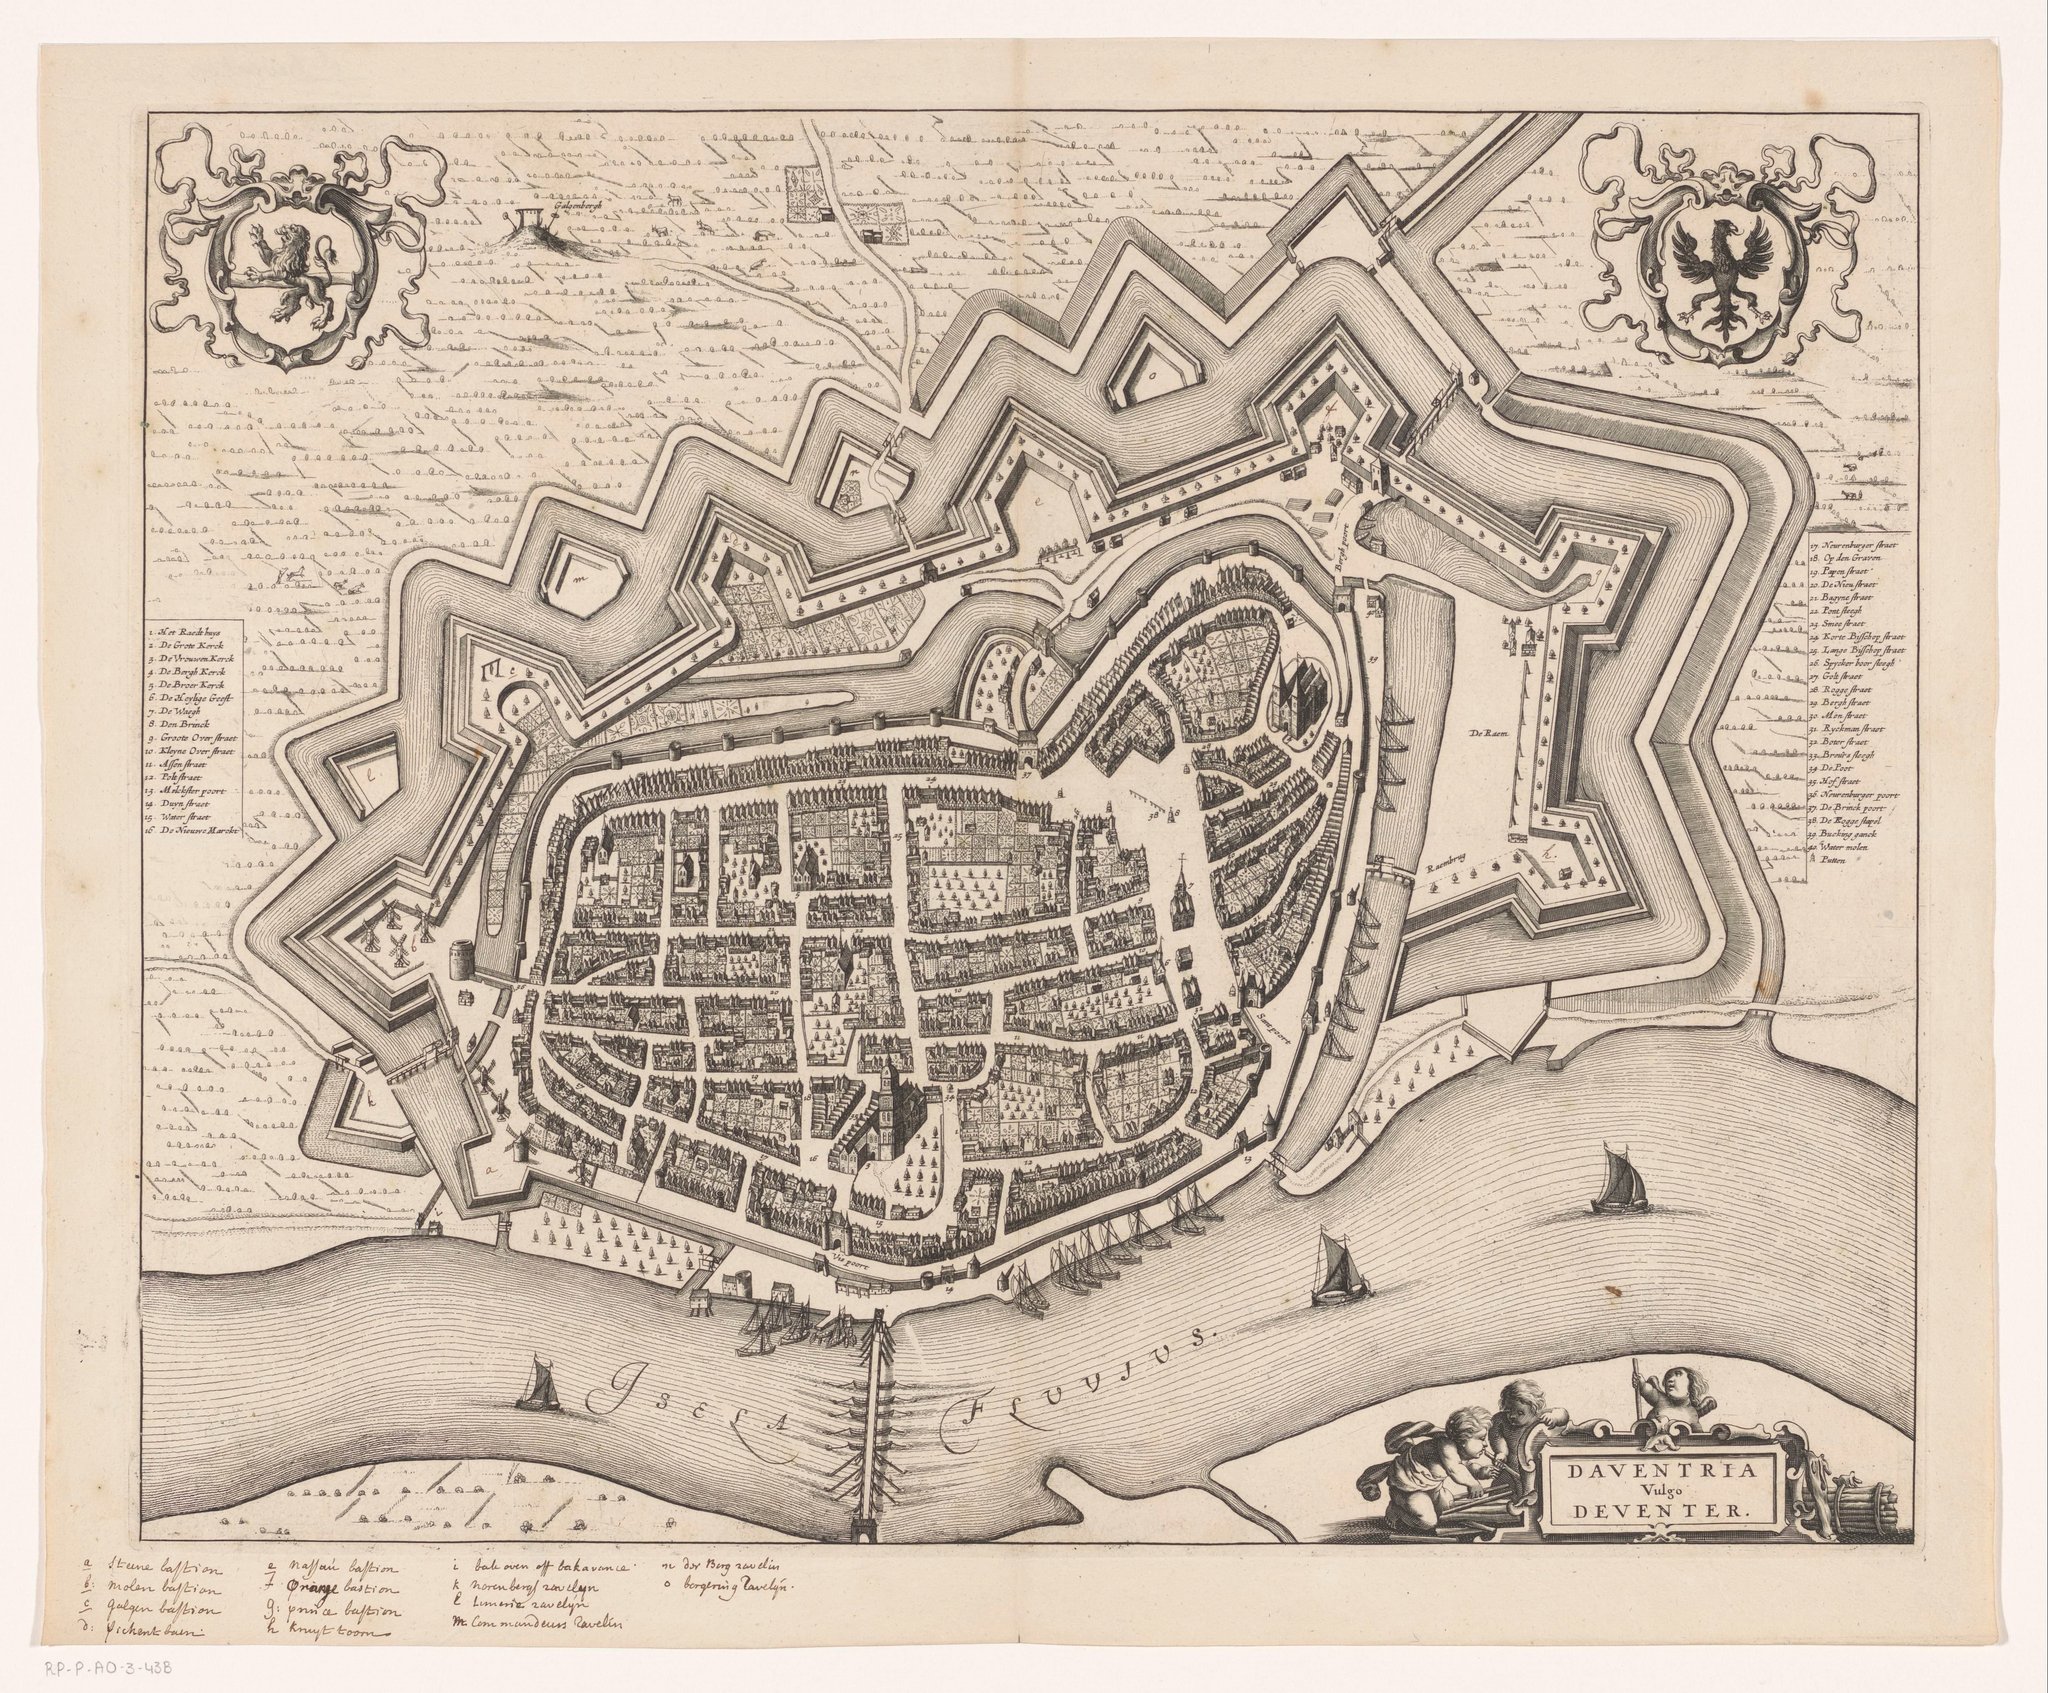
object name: area plan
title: Plattegrond van Deventer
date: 1657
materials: ink, paper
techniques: engraving, etching, pen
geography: amsterdam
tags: coat of arms (as symbol of the state, etc.), maps of cities, deventer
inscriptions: inscription: ‘a. steene bastion, b. molen bastion, c. galgen bastion, d. pickent baen, e. Nassau bastion, f. Orange bastion, g. prince bastion, h. kruyt toorn, i. bakoven off bakavance, k. norenbergs ravelijn, l. limerie ravelijn, m. commandeurs ravelin, n. der berg ravelin, o. bergeruig ravelijn.’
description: Plattegrond in vogelvluchtperspectief. Linksboven het wapen van Overijssel. In het midden langs de linker- en rechterrand een legenda. Rechtsboven het wapen van Deventer, rechtsonder titelcartouche. Onder de plaatrand nog een later aangebrachte legenda die verdedigingswerken op de kaart weergeeft. Corresponderende letters a t/m o ook later op kaart aangebracht.